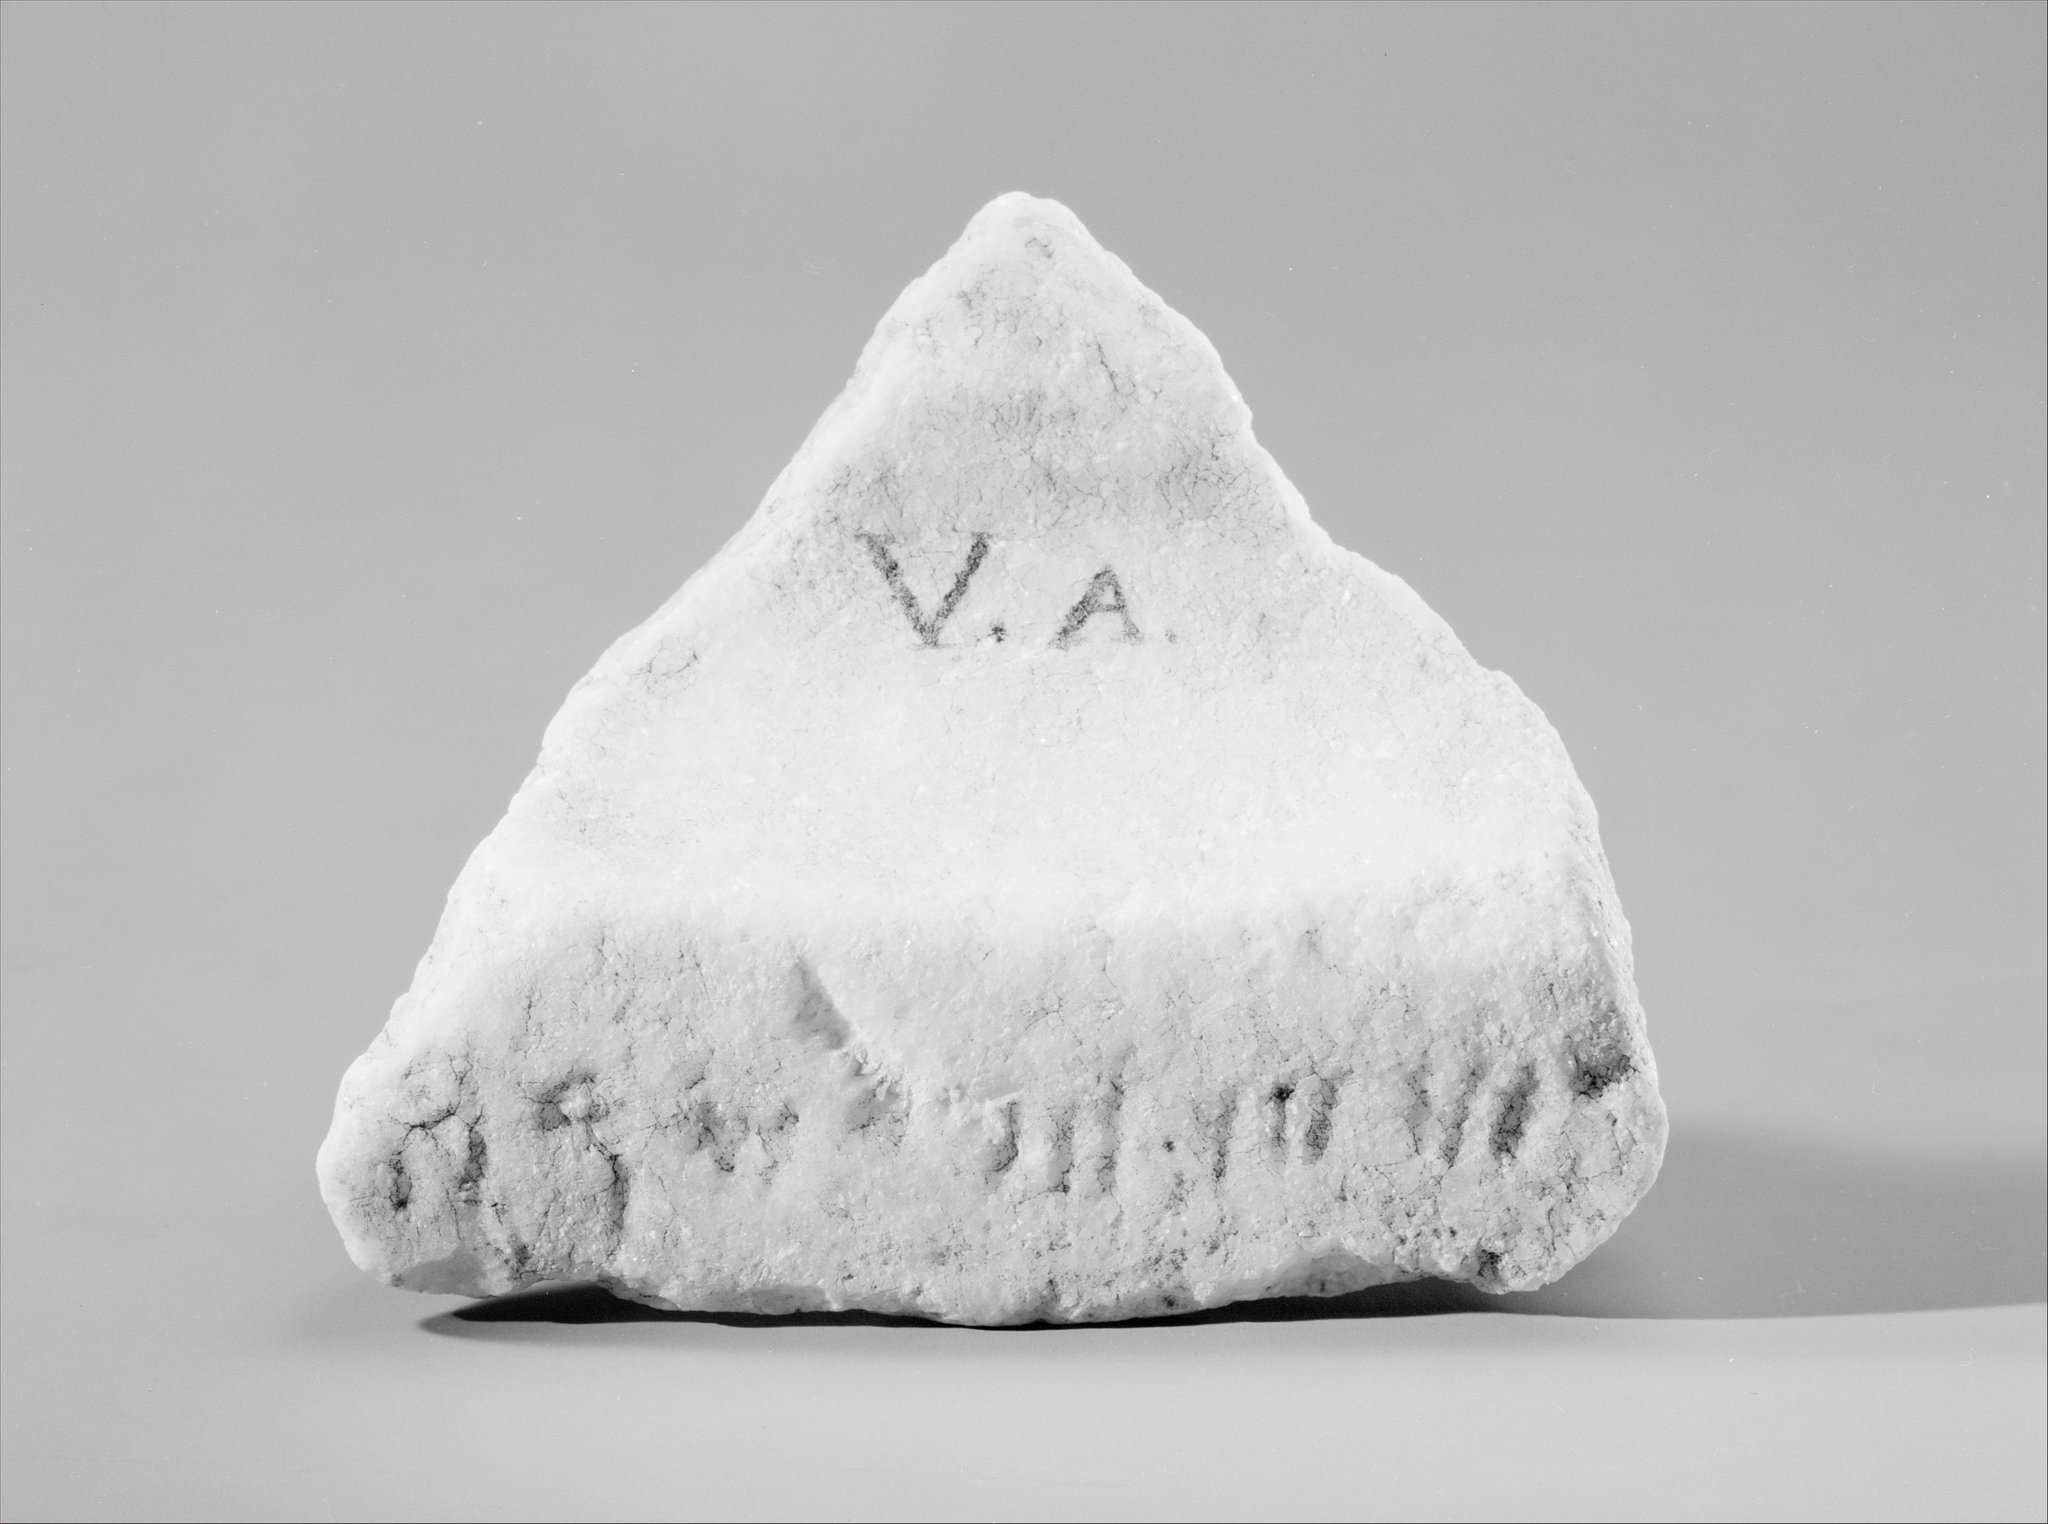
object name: bowl, fragmentary, phoenician inscription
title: Marble bowl fragment with Phoenician inscription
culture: cypriot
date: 389 BCE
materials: marble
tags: phoenician